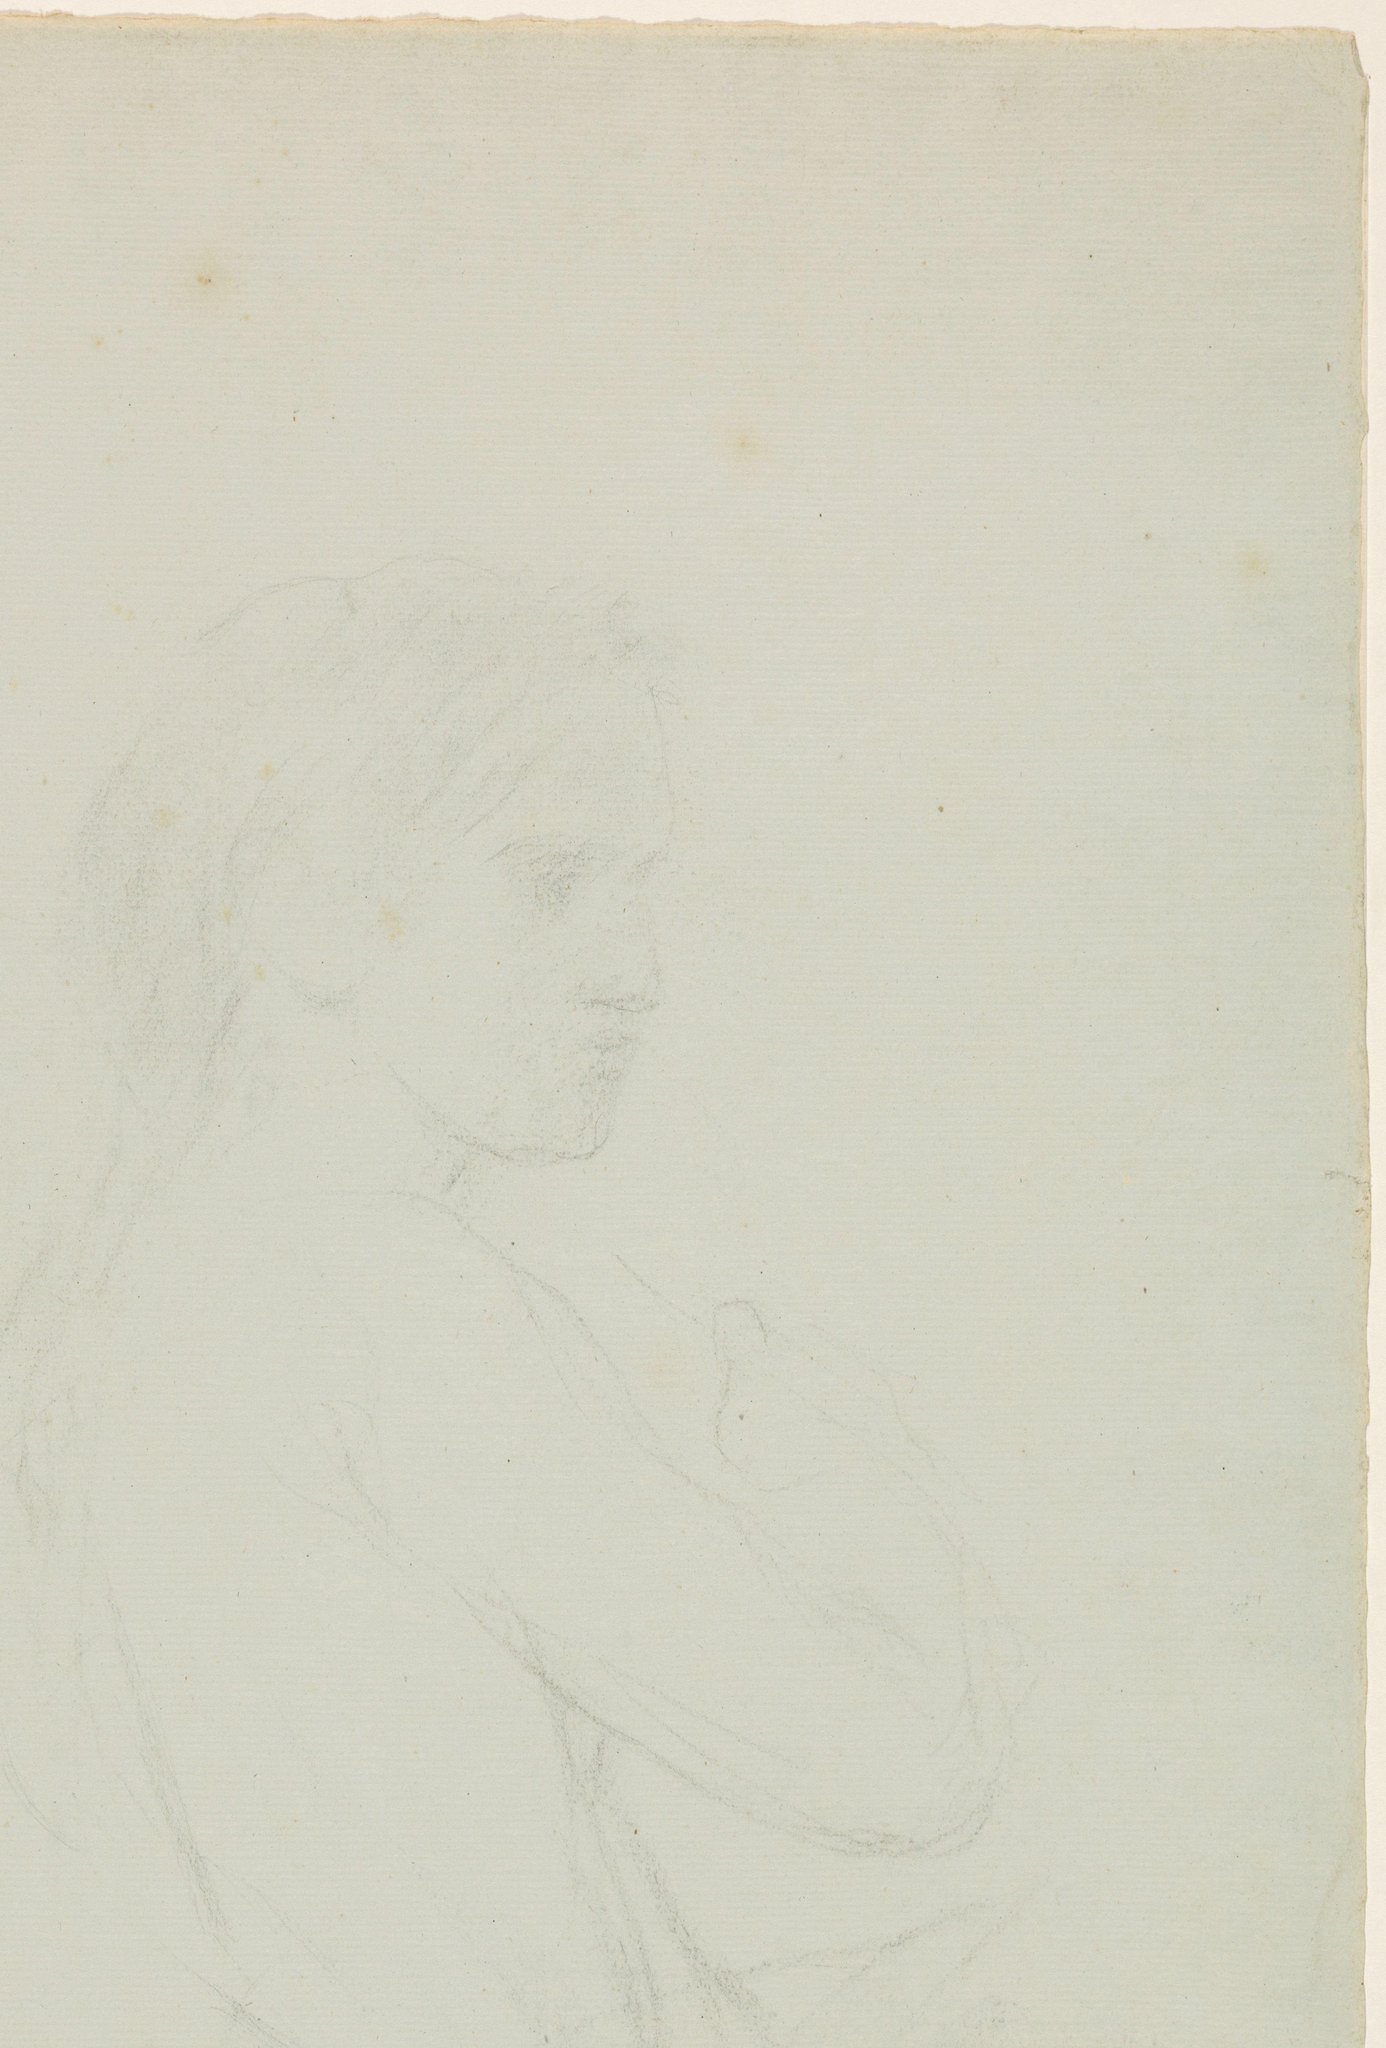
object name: drawing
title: Schets van een meisje, ten halven lijve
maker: francesco jerace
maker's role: draughtsman, sculptor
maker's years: 1854-1937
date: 1887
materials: chalk, paper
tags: girl (child between toddler and youth), standing figure - aa - female human figure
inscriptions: date